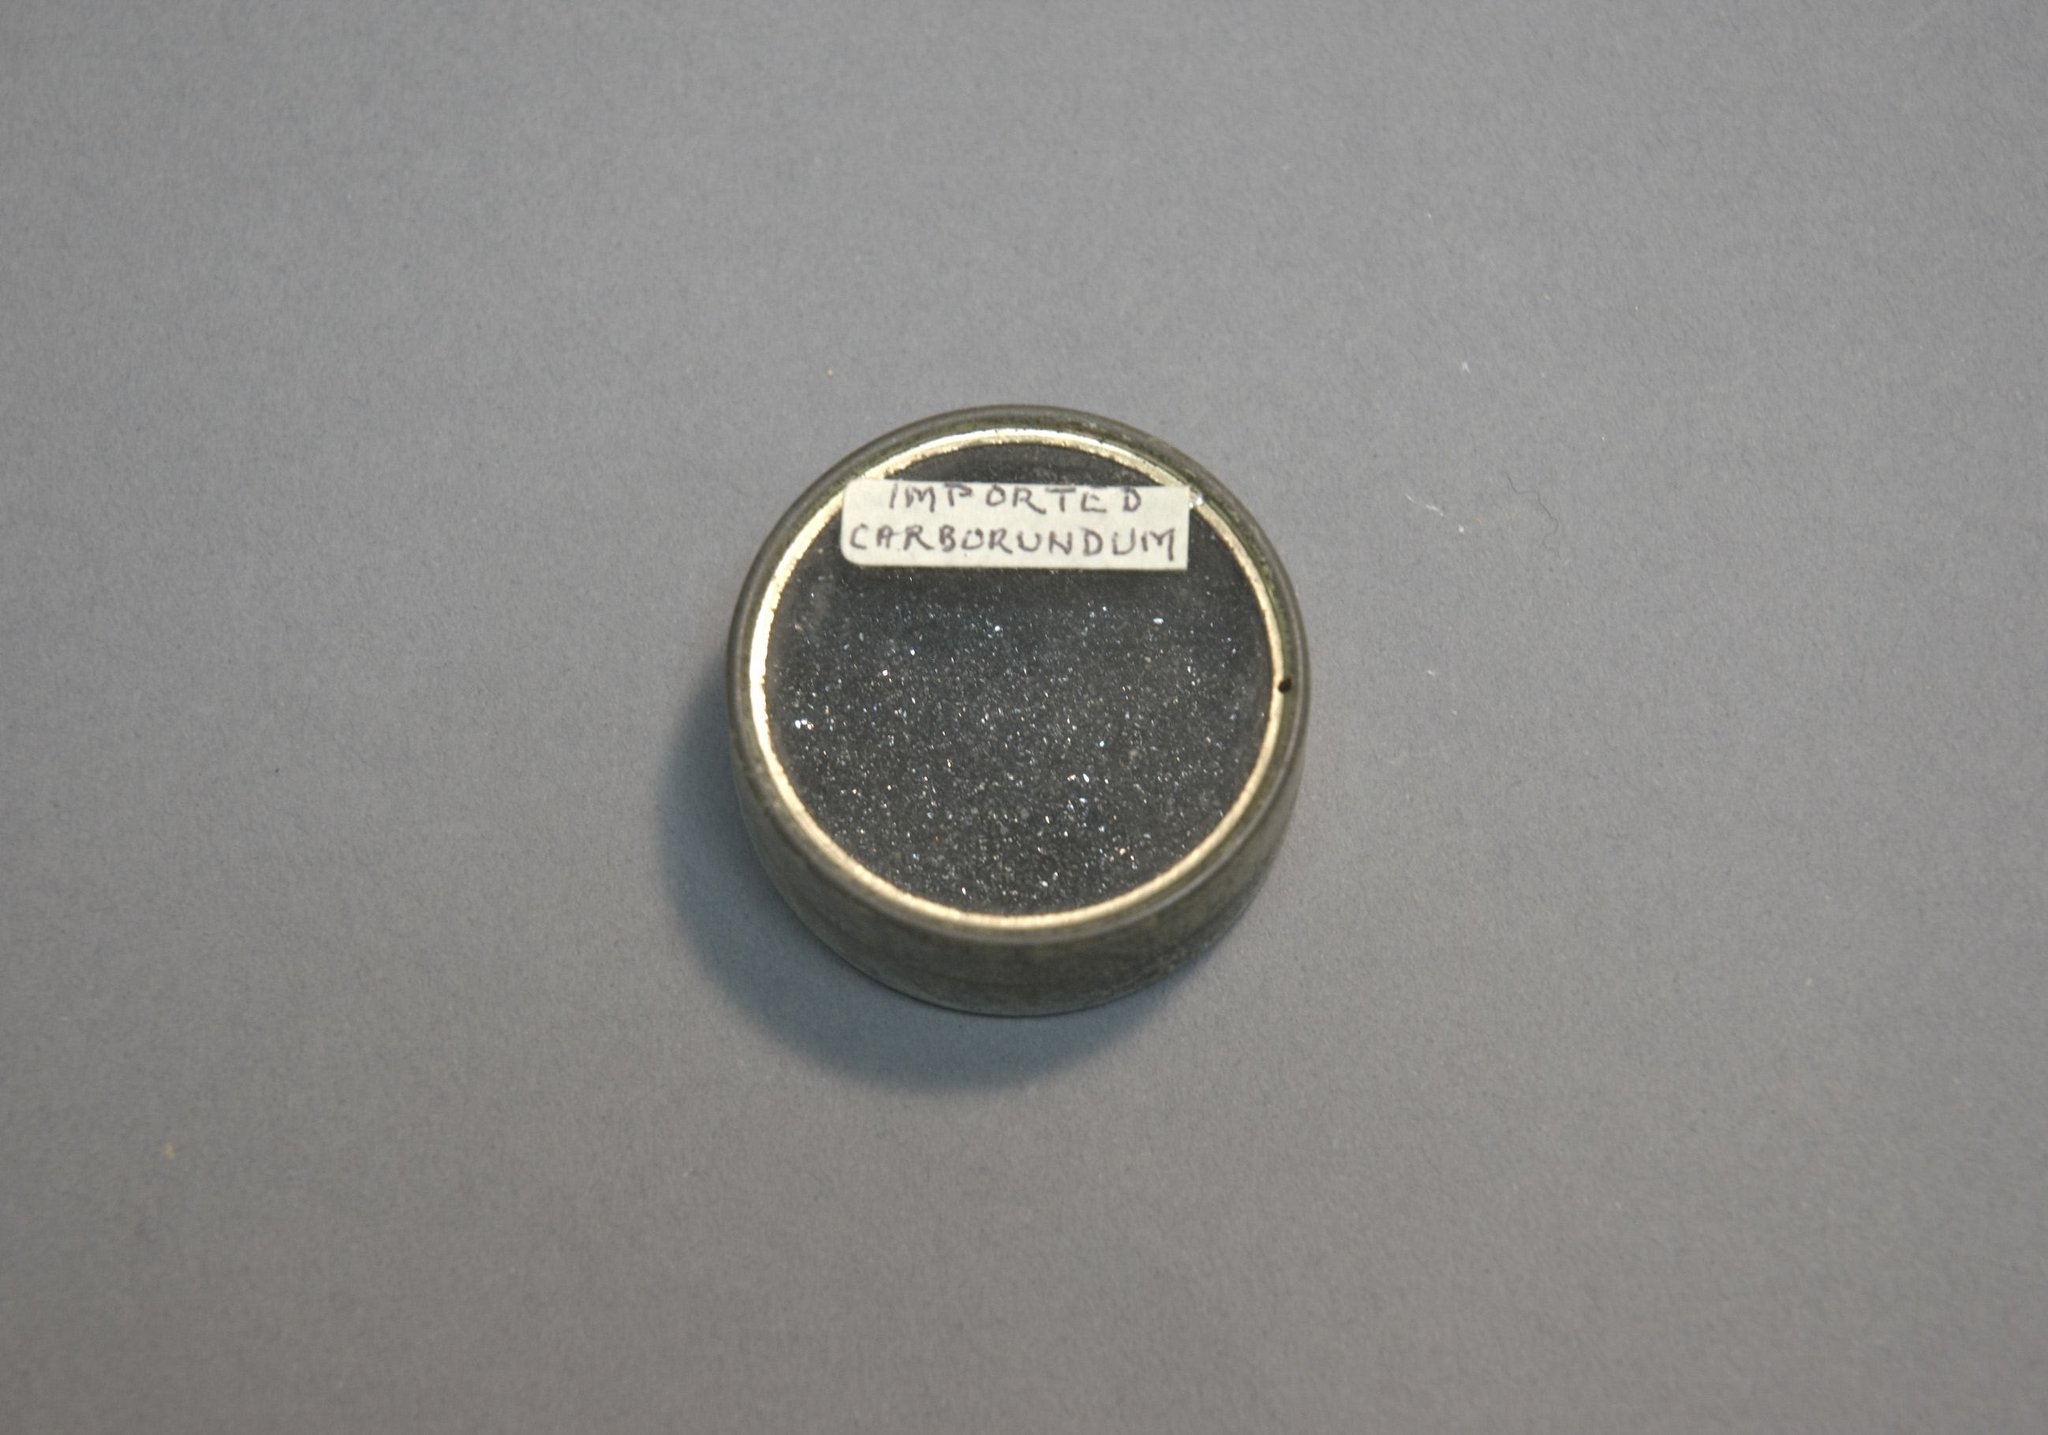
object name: jade carving material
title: Container of Imported Carborundum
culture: chinese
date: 1901-2000